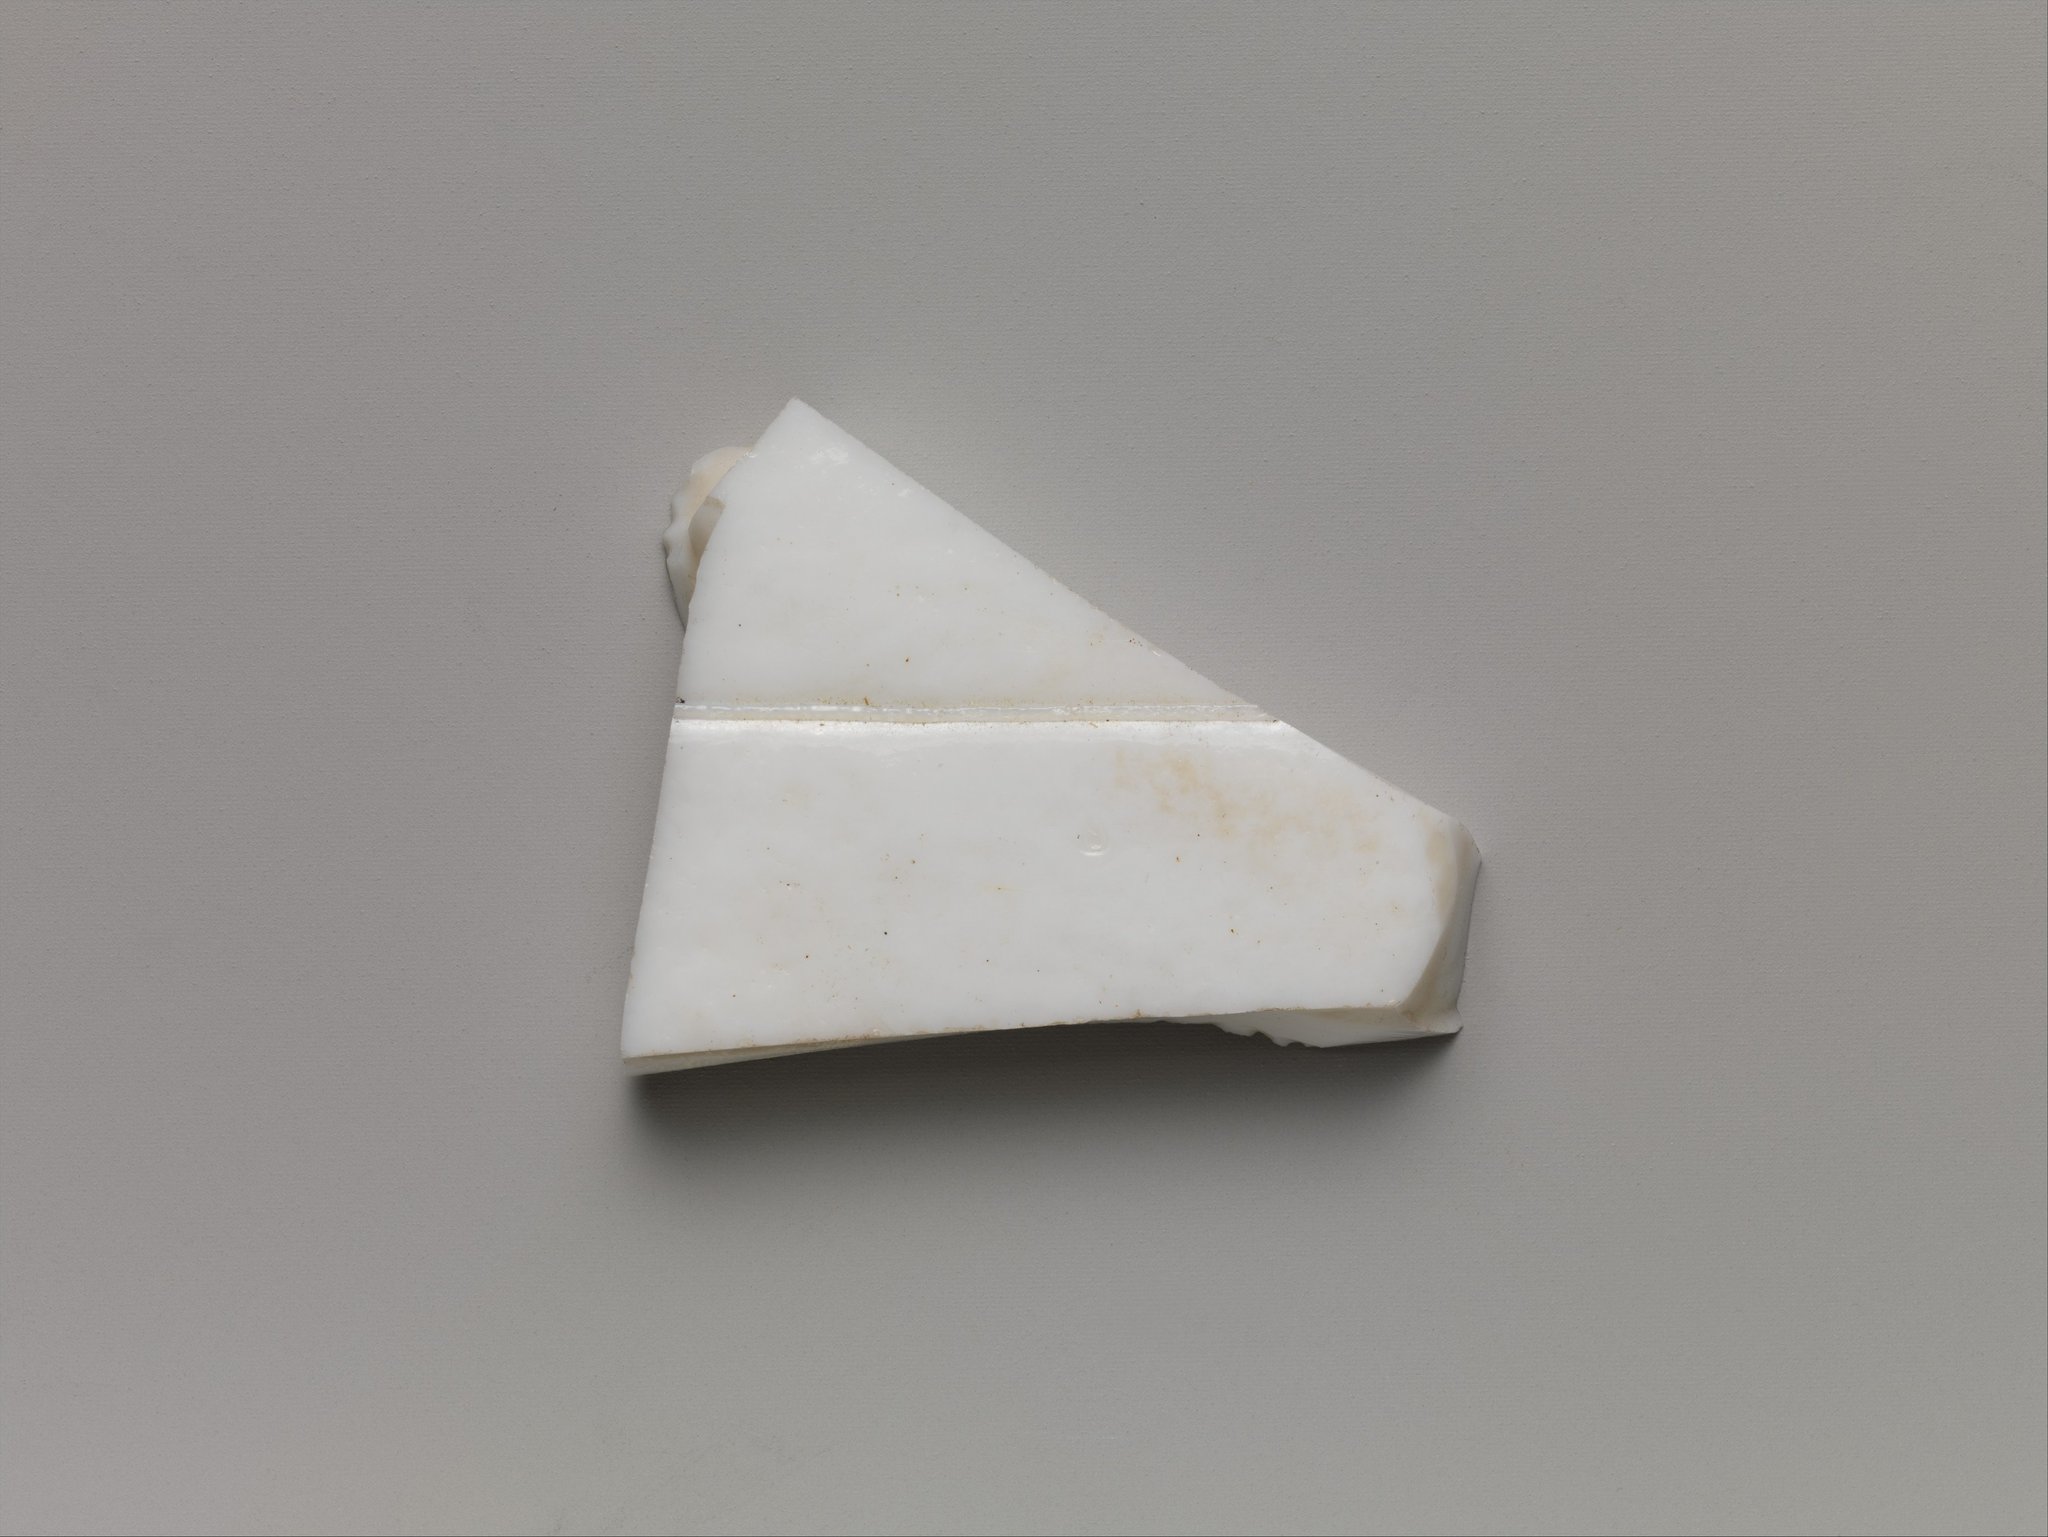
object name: fragment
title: Fragment from sample set of Chinese cloisonné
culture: chinese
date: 1867-1900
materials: copper alloy, enamel, glass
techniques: enamel